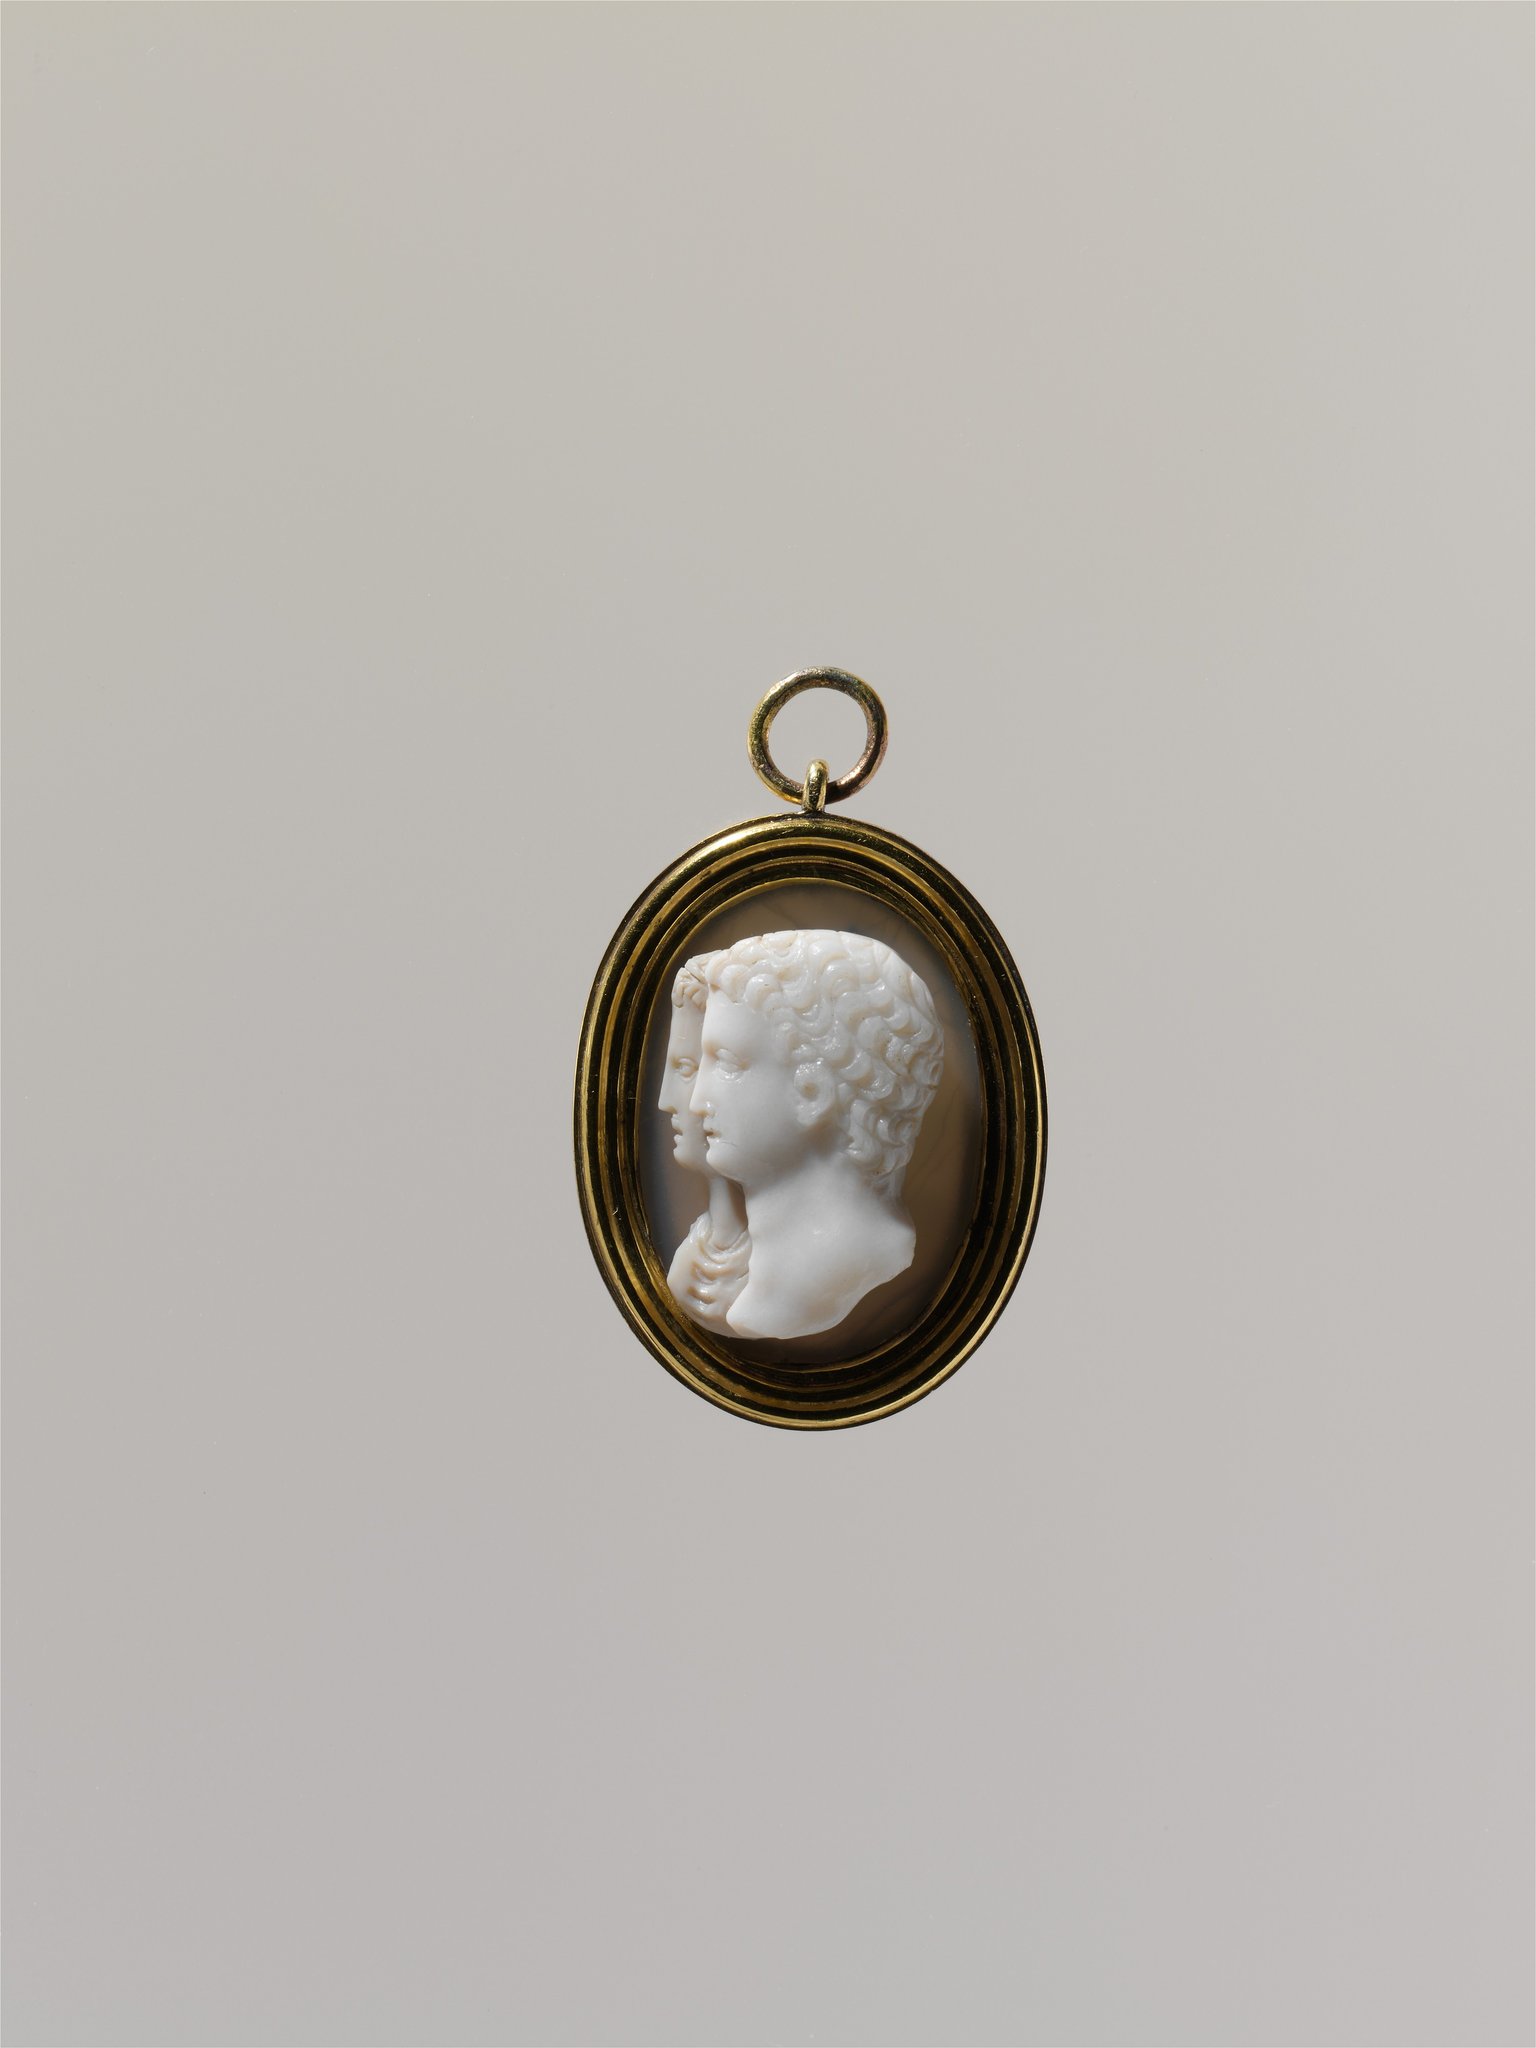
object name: cameo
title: Jugate heads of Germanicus (15 B.C.–19 A.D.) and Agrippina (d. 33 A.D.)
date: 1601-1700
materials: onyx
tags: men,profiles,women